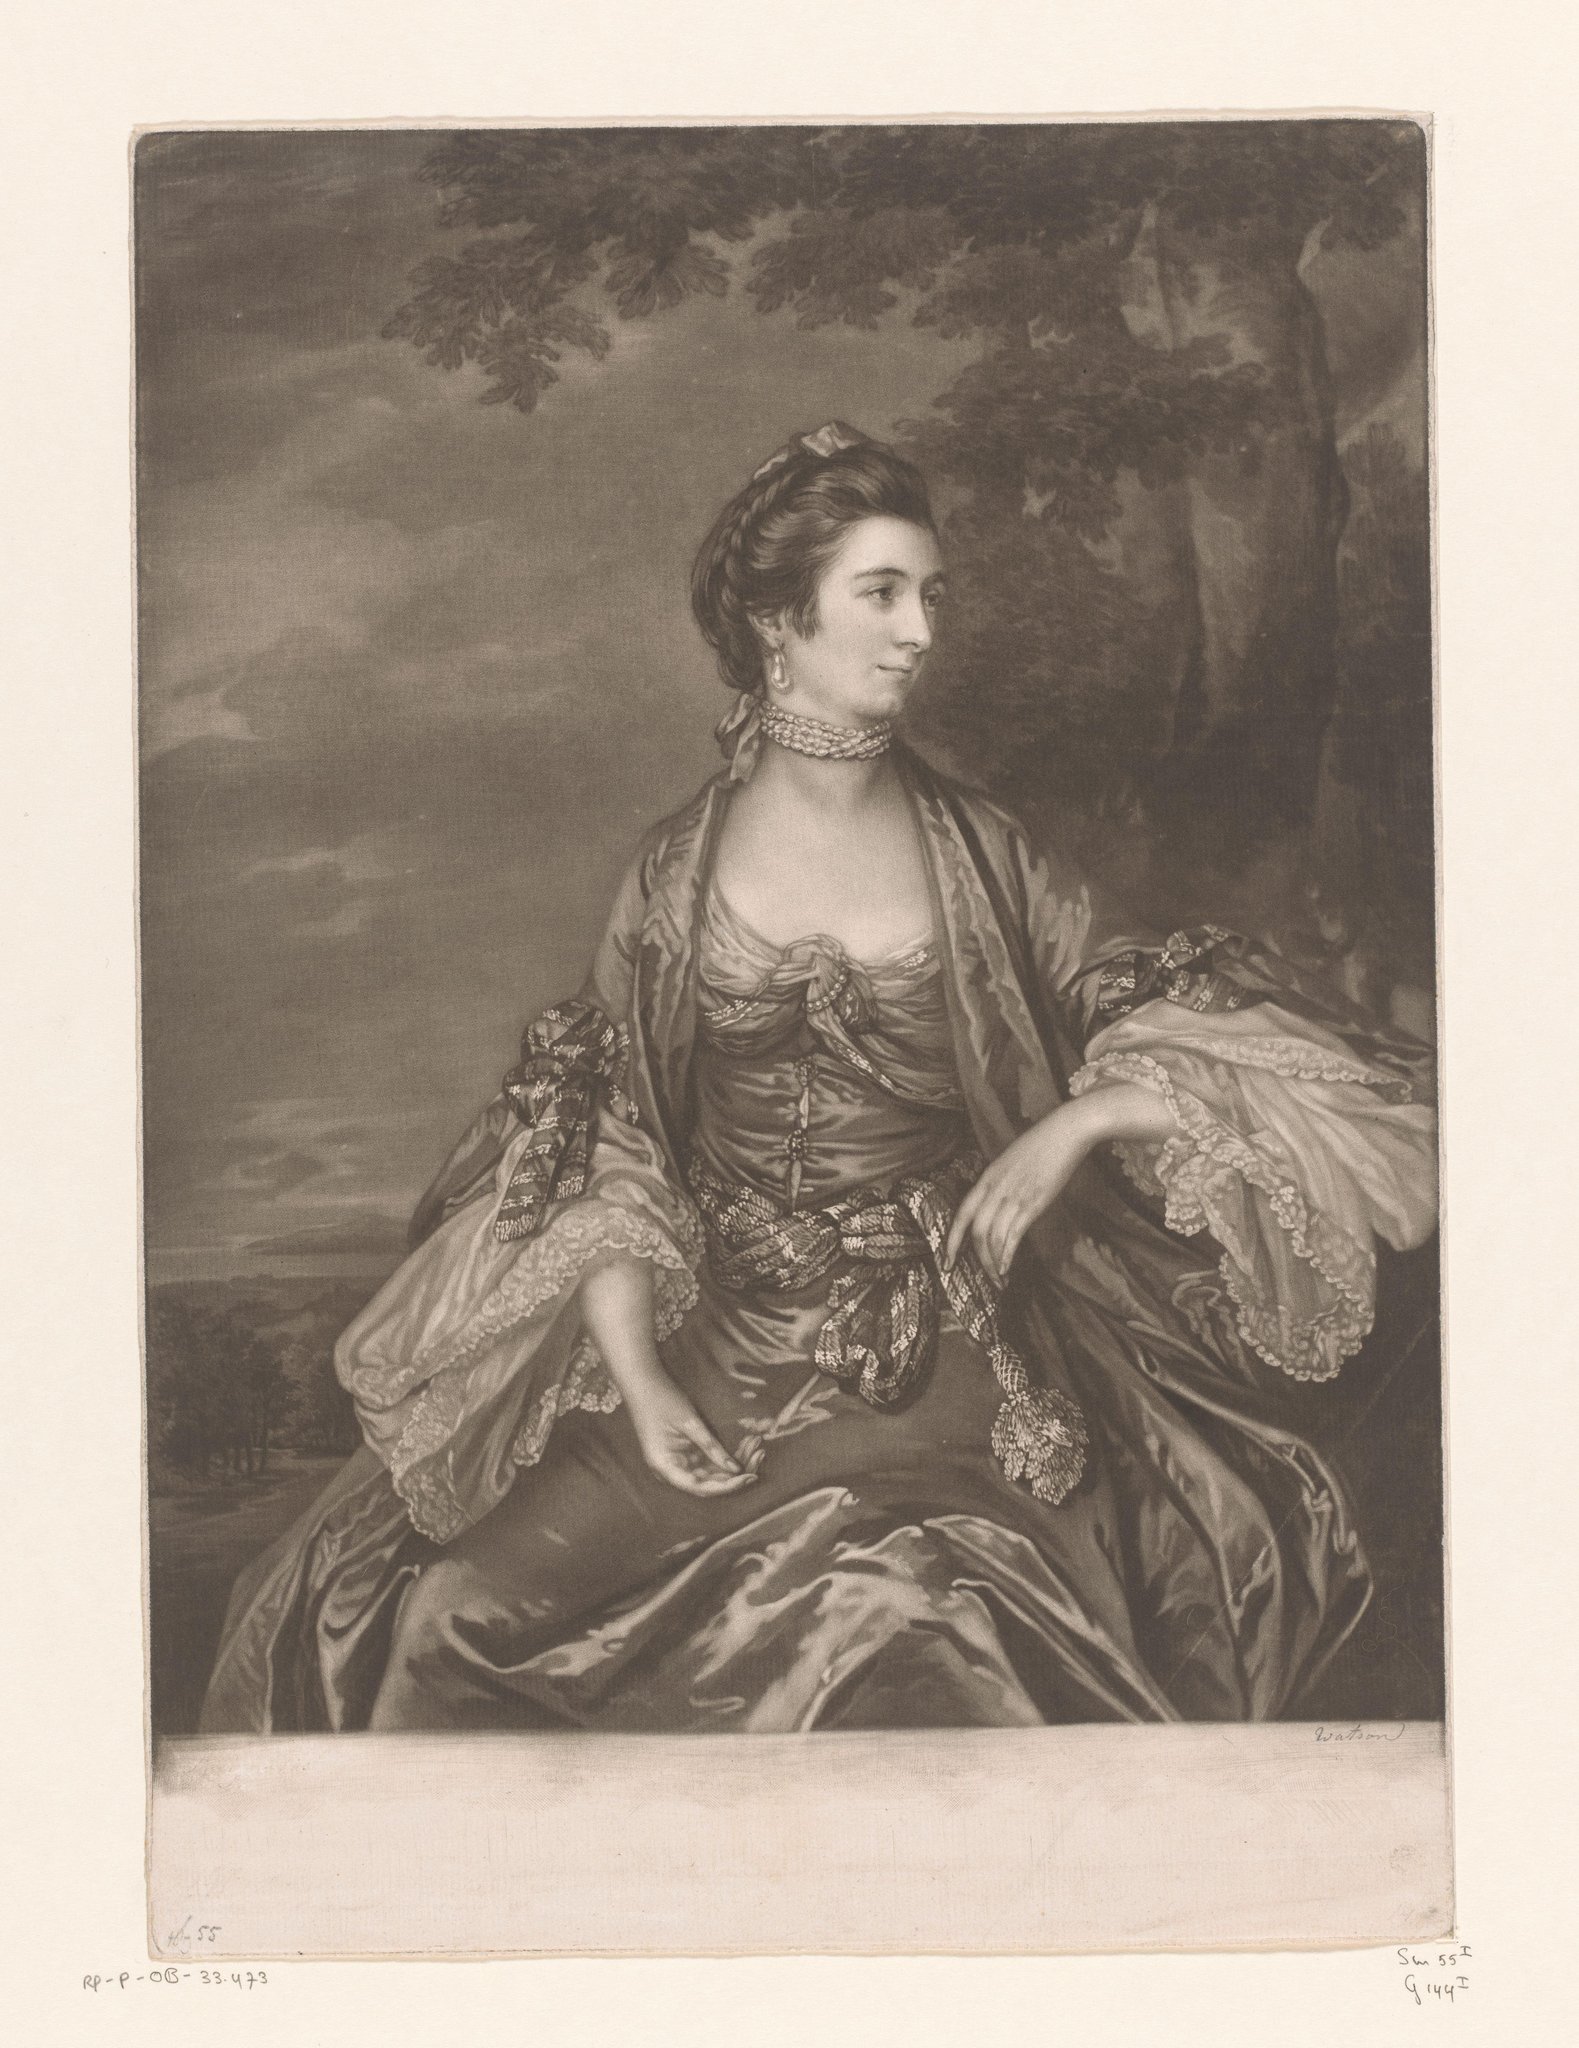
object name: print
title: Portret van Anne Fortescue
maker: james watson (prentmaker)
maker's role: print maker, publisher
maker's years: 1740-1790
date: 1755-1790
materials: paper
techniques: mezzotint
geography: london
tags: historical persons - bb - woman, pearl; pearl necklace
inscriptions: collector's mark: Lugt 240